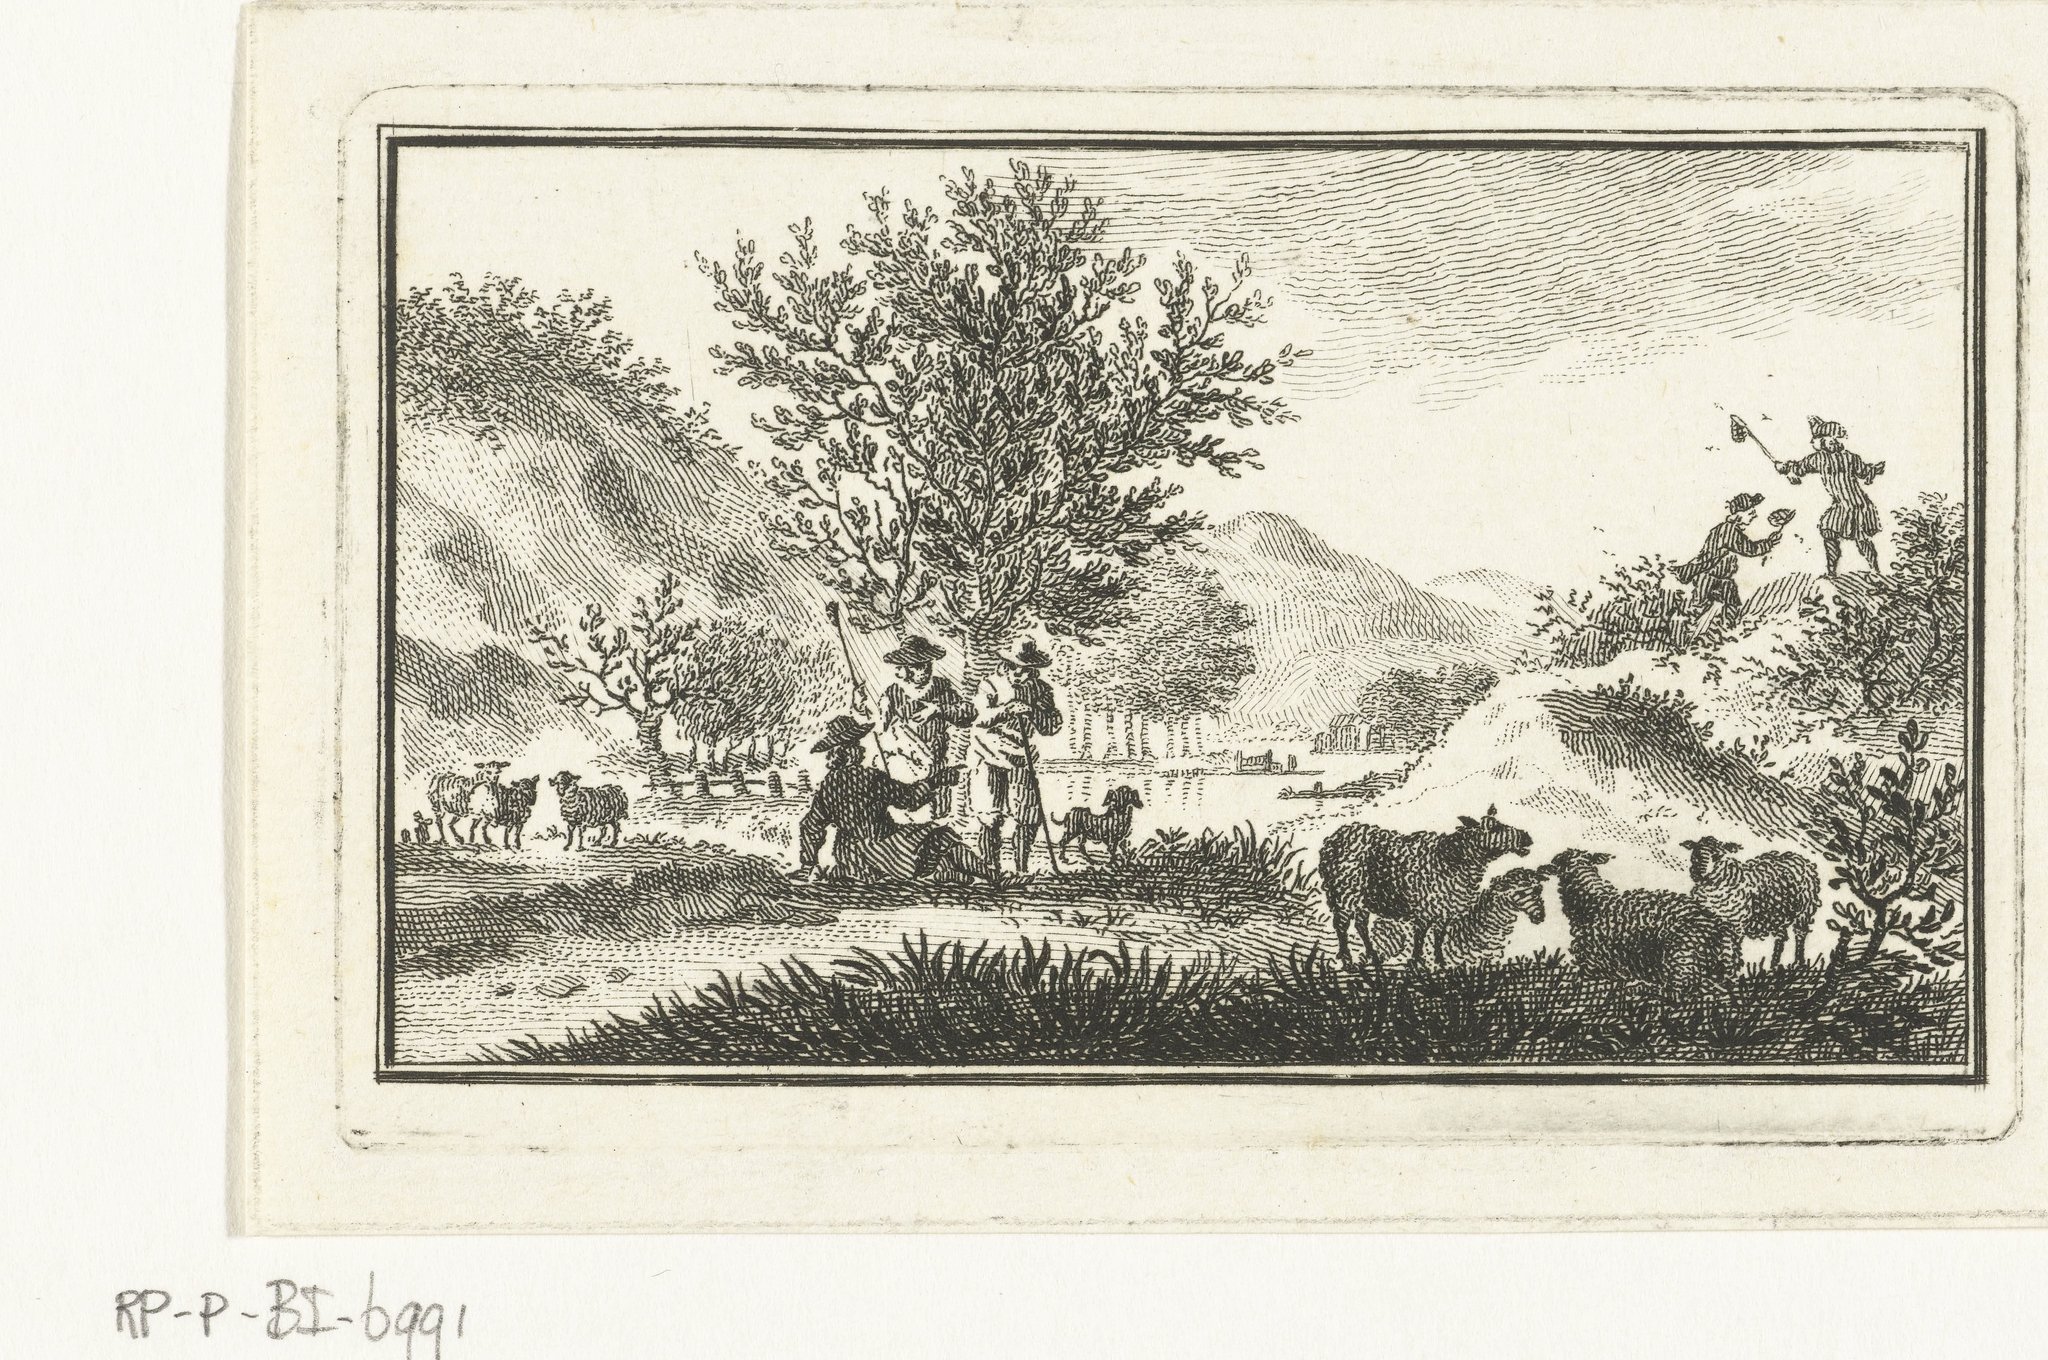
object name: print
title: Duinlandschap met rustende herders en mannen die vlinders vangen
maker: abraham delfos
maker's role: draughtsman, painter, print maker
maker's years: 1731-1820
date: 1764-1765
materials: paper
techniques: etching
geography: leiden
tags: dunes (sea not visible); in the dunes, hunting butterflies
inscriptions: collector's mark: Lugt 240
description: Prent in latere staat gebruikt voor: Dirk Kuipers, Dichtlievende mengelingen, Leiden, Wed. A. Honkoop en Zoon & C. van Hoogeveen Jr., 1764-1765, deel 2, p. 103